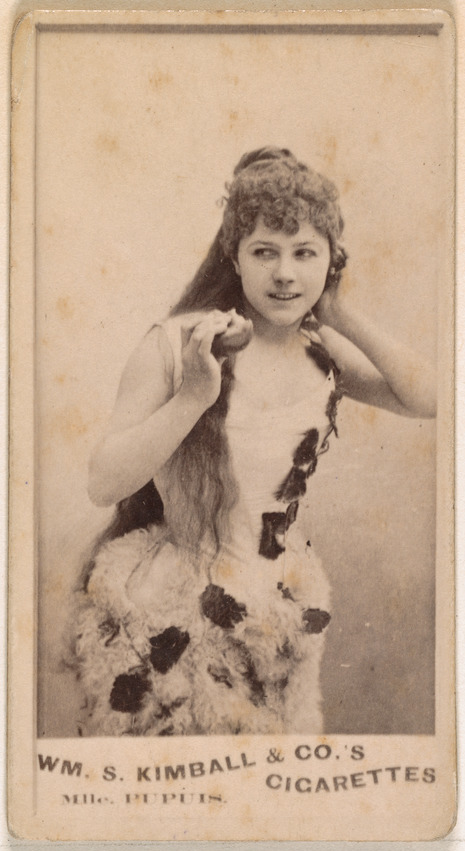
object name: photograph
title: Mlle. Pupuis, from the Actresses series (N203) issued by Wm. S. Kimball & Co.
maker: william s. kimball & company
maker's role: publisher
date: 1889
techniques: color lithograph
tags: portraits,women,actresses